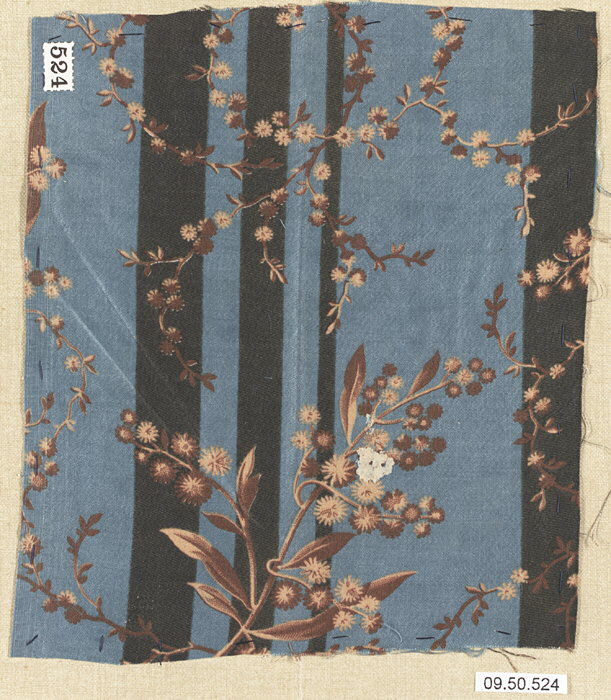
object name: piece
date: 1801-1900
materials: cotton